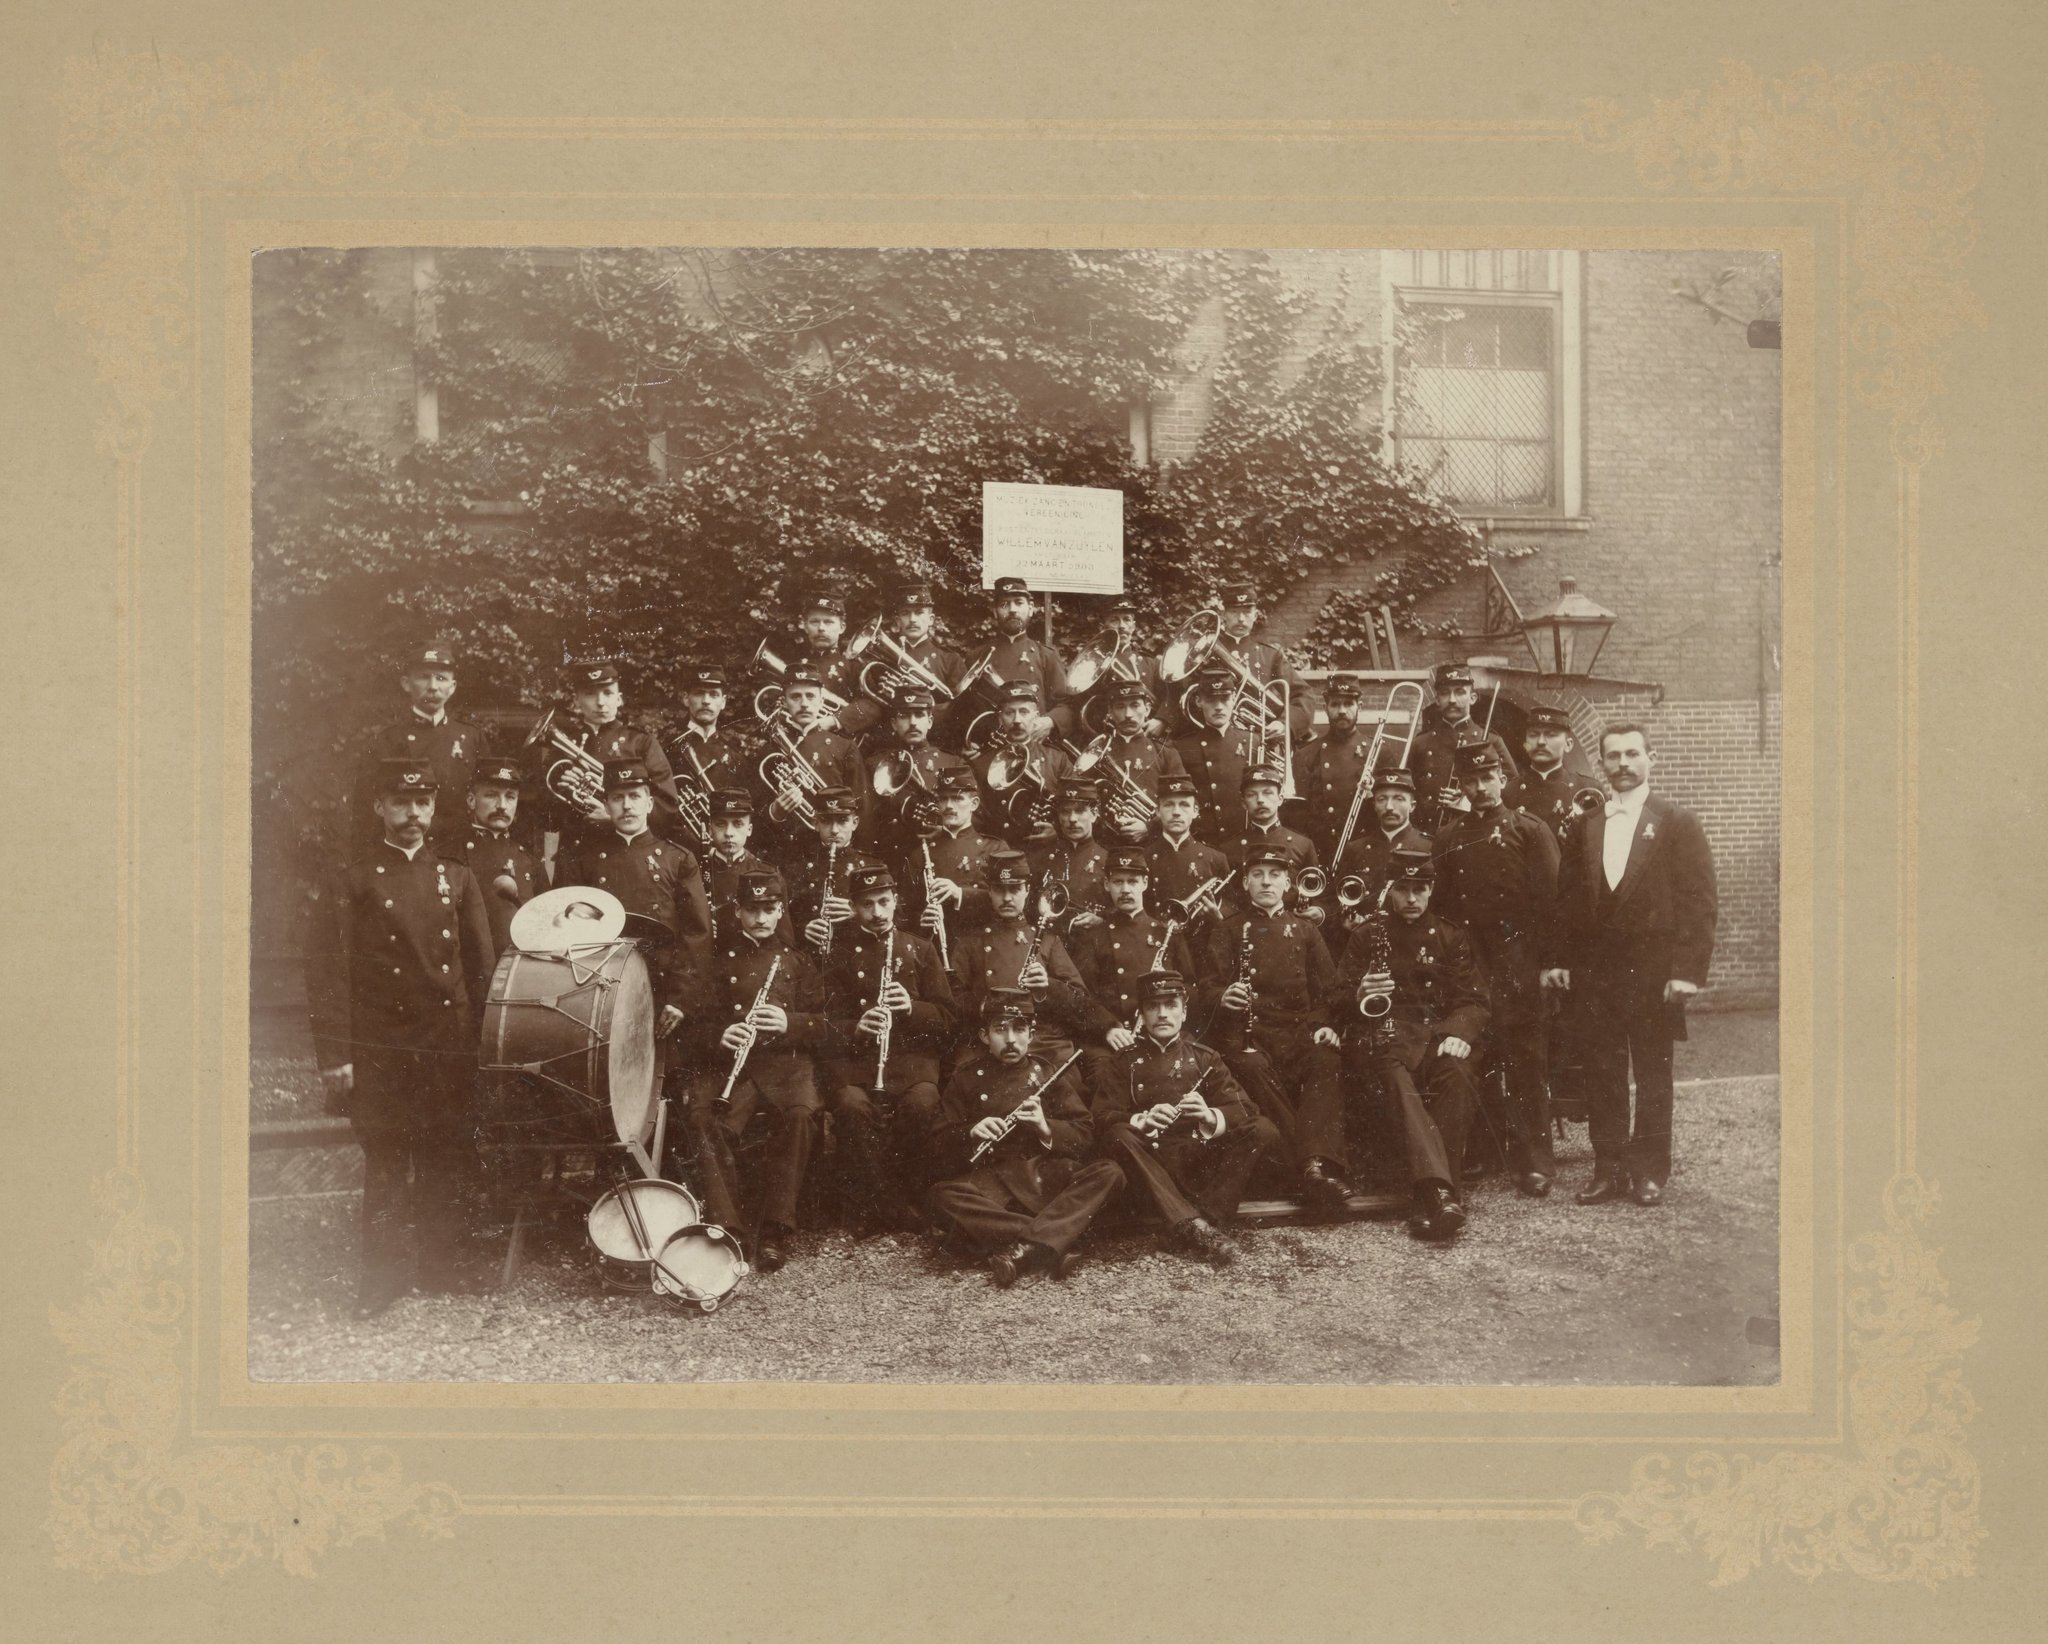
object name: photograph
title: Groepsportret muziek- zang- en toneelvereniging 'Willem van Zuylen' van post-en telegraafbeambten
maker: cornelis leenheer sr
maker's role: fotograaf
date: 1900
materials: cardboard, photographic support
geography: amsterdam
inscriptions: stamp: ‘Photografie Artistique 45 Utrechtschestr. 45 Corn. Leenheer Sr. Amsterdam’